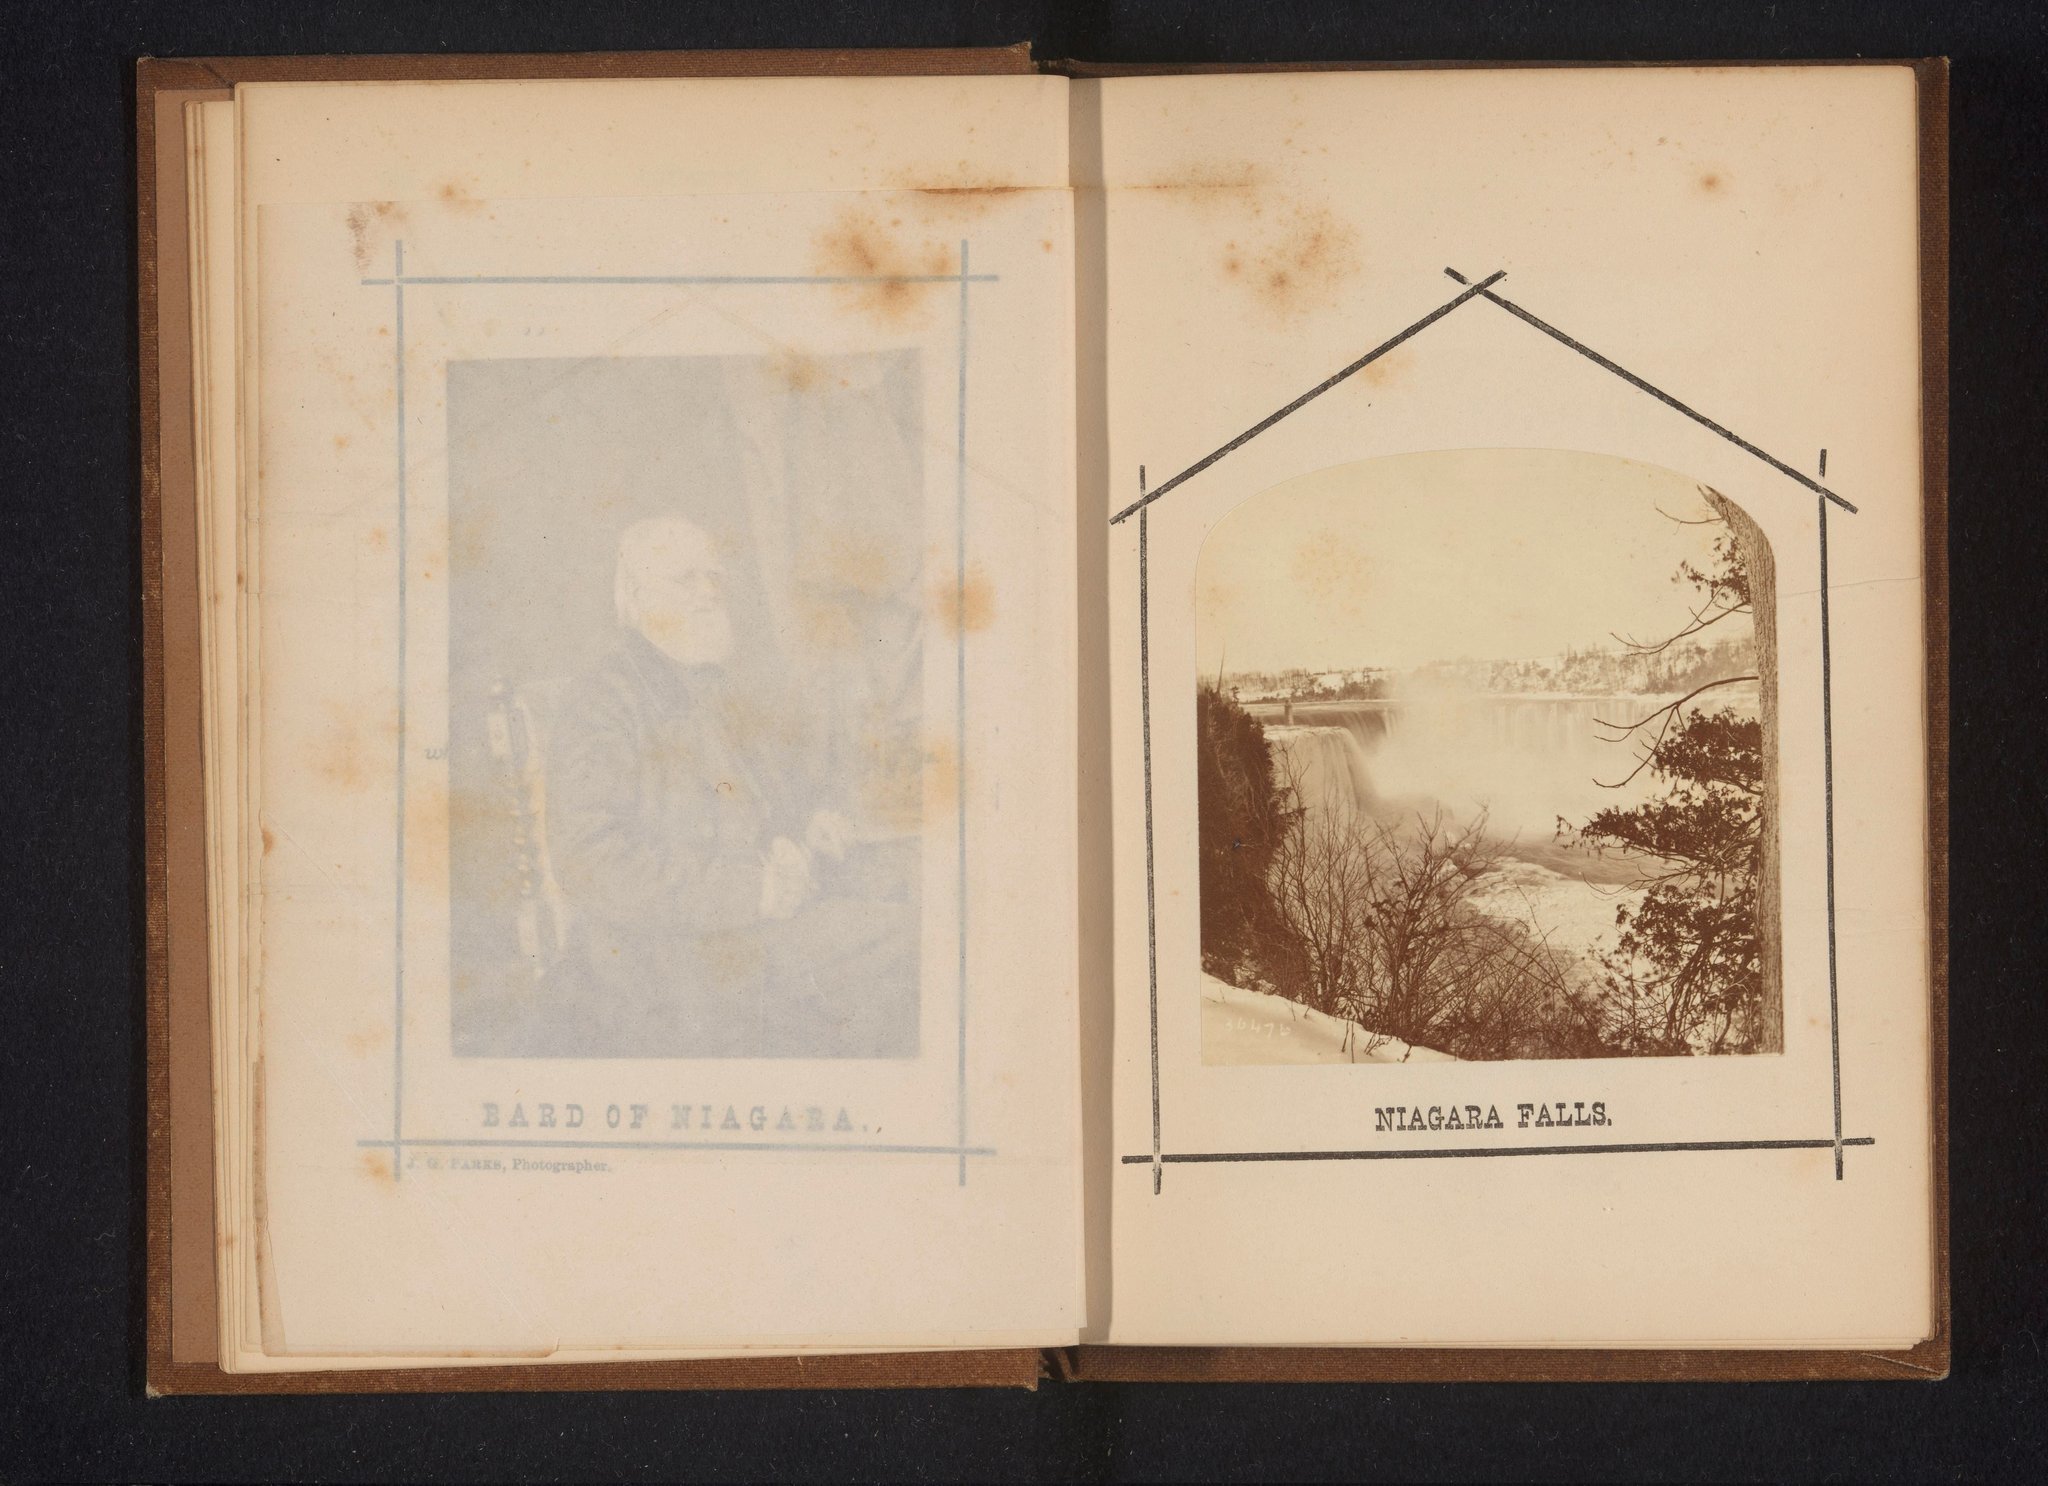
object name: photograph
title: Gezicht op de Niagara watervallen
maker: j.g. parks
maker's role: fotograaf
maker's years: 1836-1895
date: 1862-1872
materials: photographic support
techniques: albumen print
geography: niagara falls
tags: waterfall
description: Foto tussen titelpagina en het eerste gedicht.